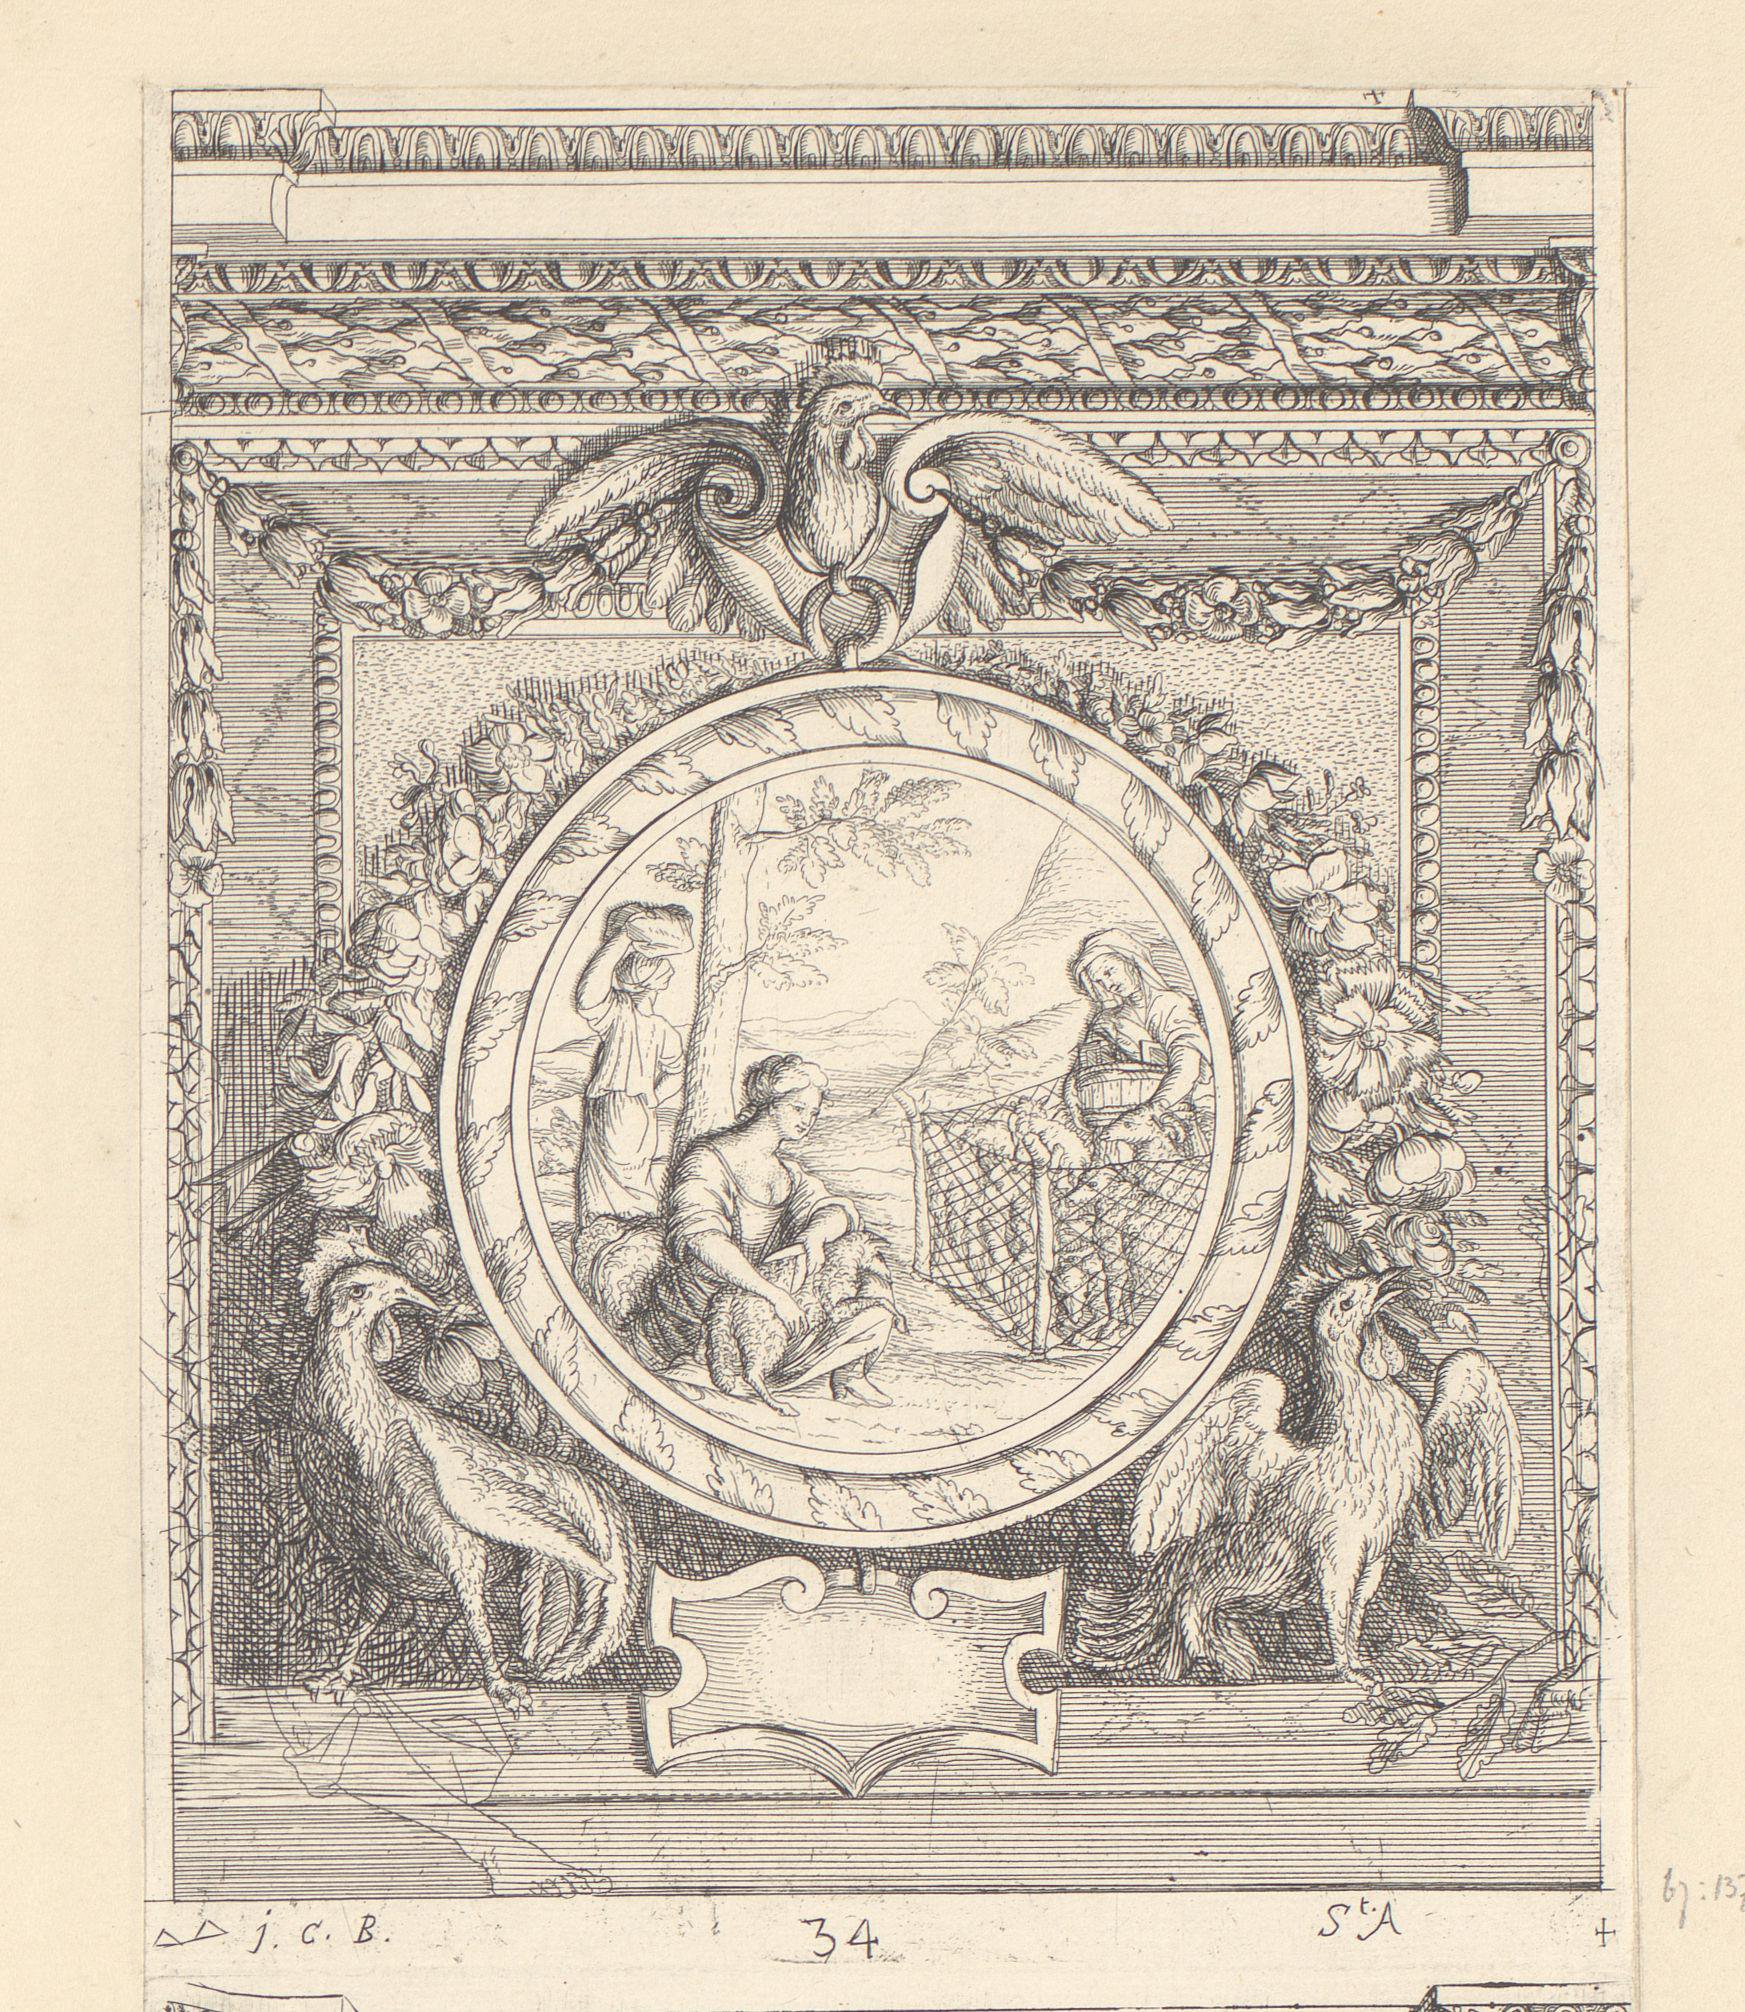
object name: album leaf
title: La Petite Gallerie du Louvre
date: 1695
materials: paper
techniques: etching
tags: june and its 'labours', predatory birds: eagle - ff - fabulous animals (sometimes wrongly called 'grotesques'); 'mostri' (ripa), shearing (sheep)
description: Een adelaar aan weerszijden van een medaillon met daarop schapen scherende vrouwen. Deze prent maakt deel uit van een album.